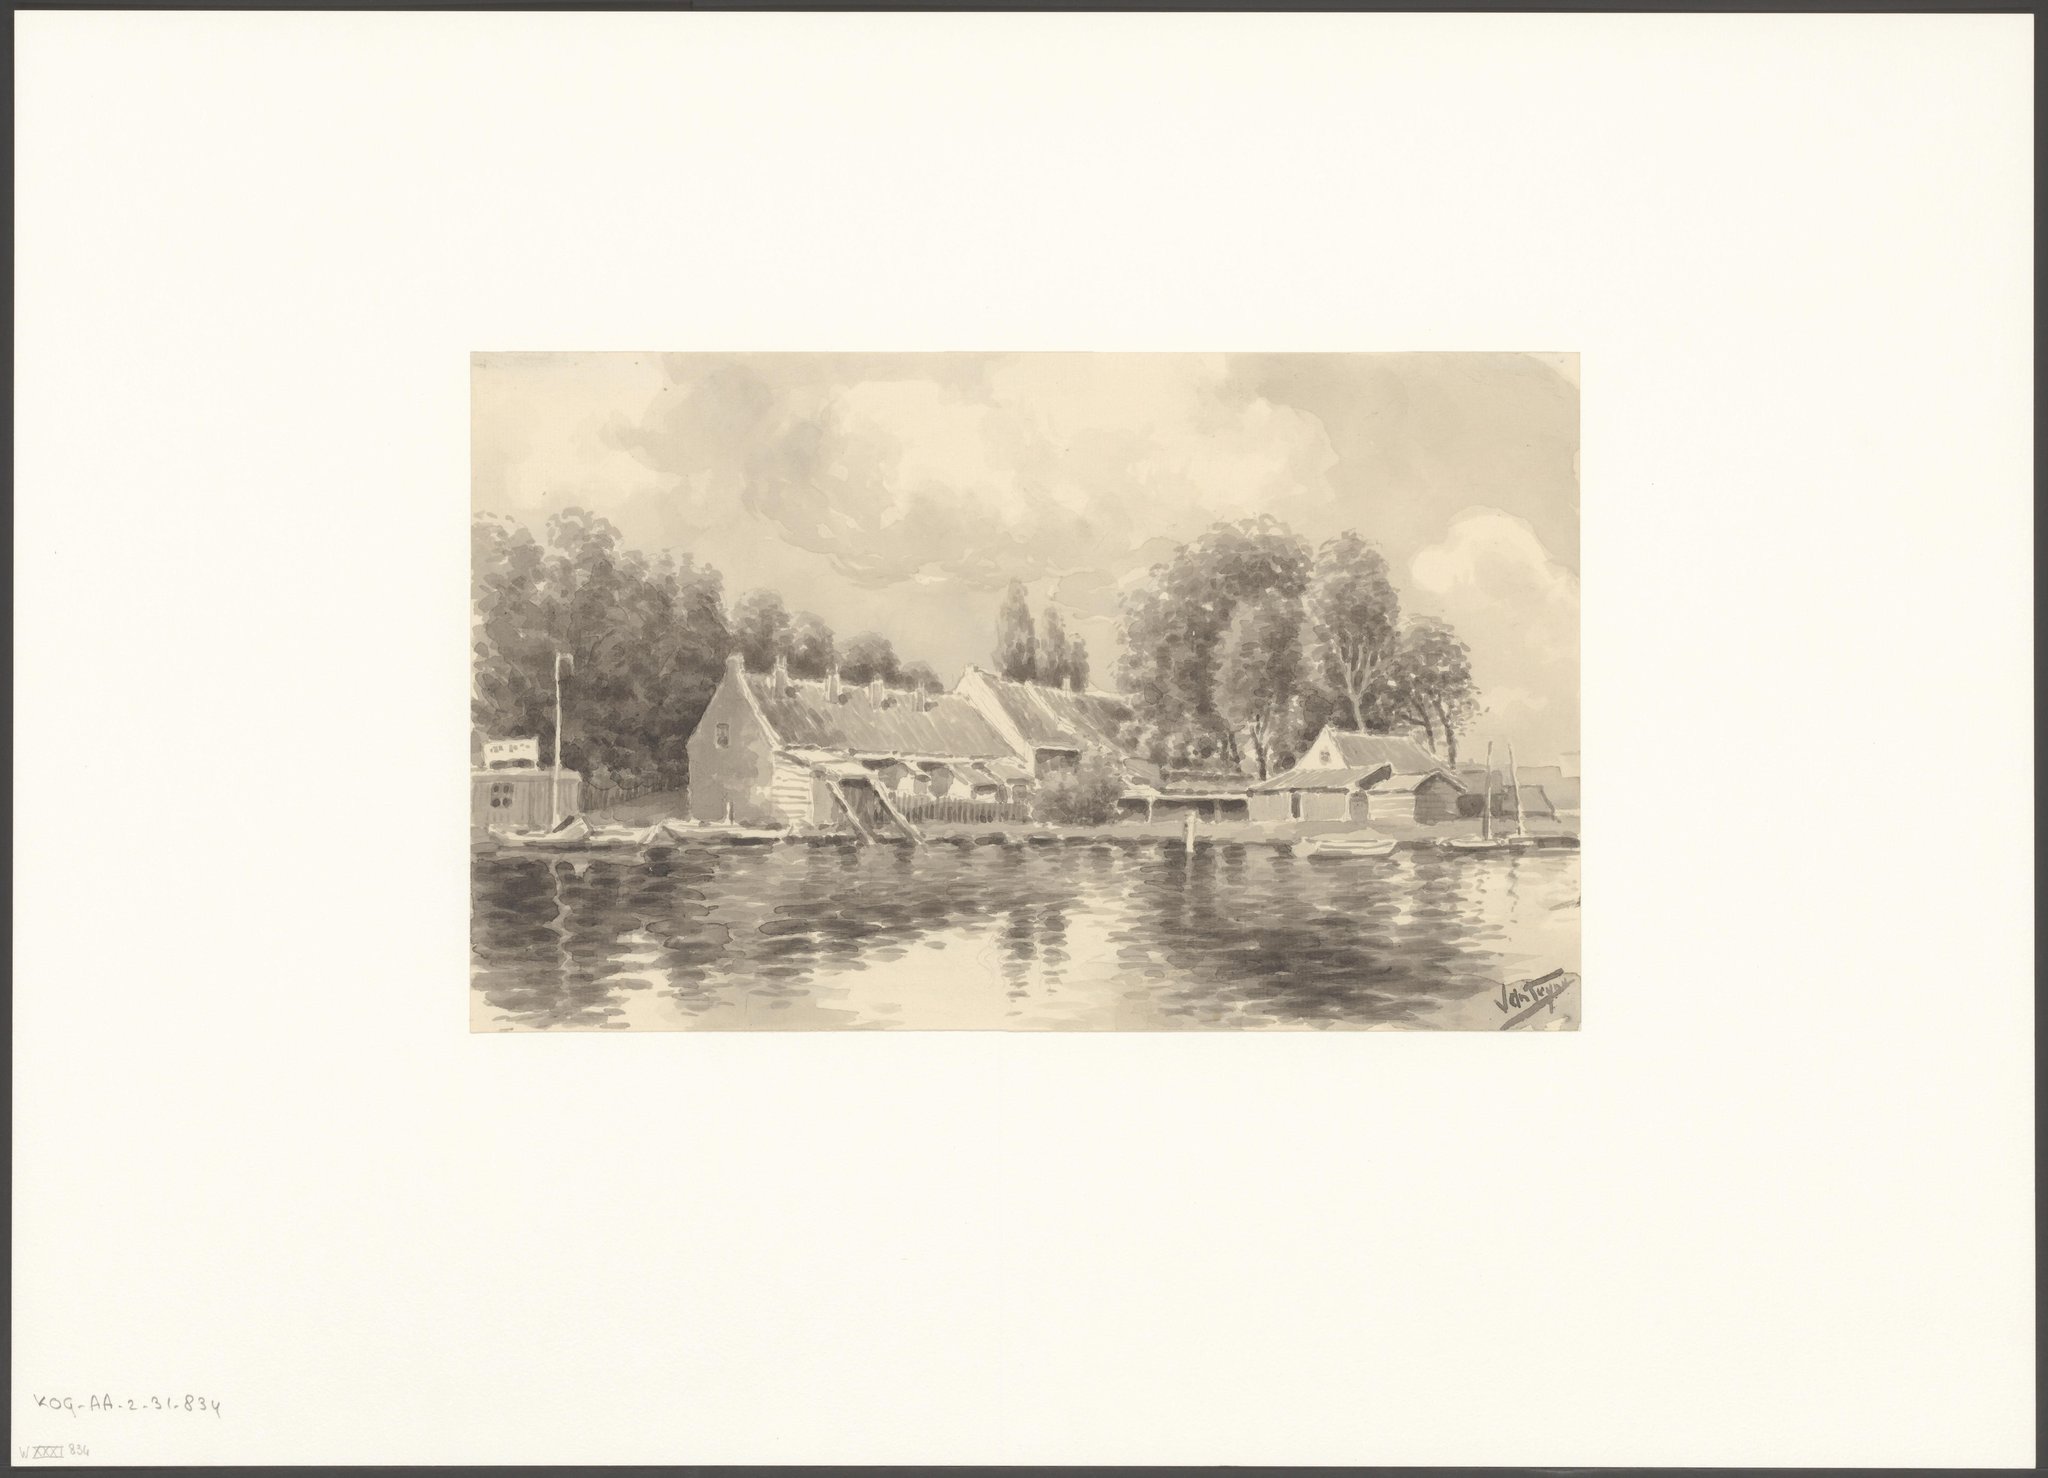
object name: drawing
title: Gezicht op de Schinkel nabij Huis Te Vraag, gezien vanaf het rangeerterrein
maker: anthonie van teijn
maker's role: draughtsman, painter, print maker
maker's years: 1863-1943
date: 1910-1927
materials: ink, paper, pencil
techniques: brush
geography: amsterdam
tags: city-view in general; 'veduta', canal, the usual house or row of houses, boat propelled by man or animal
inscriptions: collector's mark: Lugt 800a, inscription: ‘Aan den Schinkel (...) Oct 1927 / vanEck’, inscription: ‘Schinkel’, signature: ‘VanTeyne’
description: Tekening binnen de Atlas Van Eck ingedeeld op wijknummer 31.